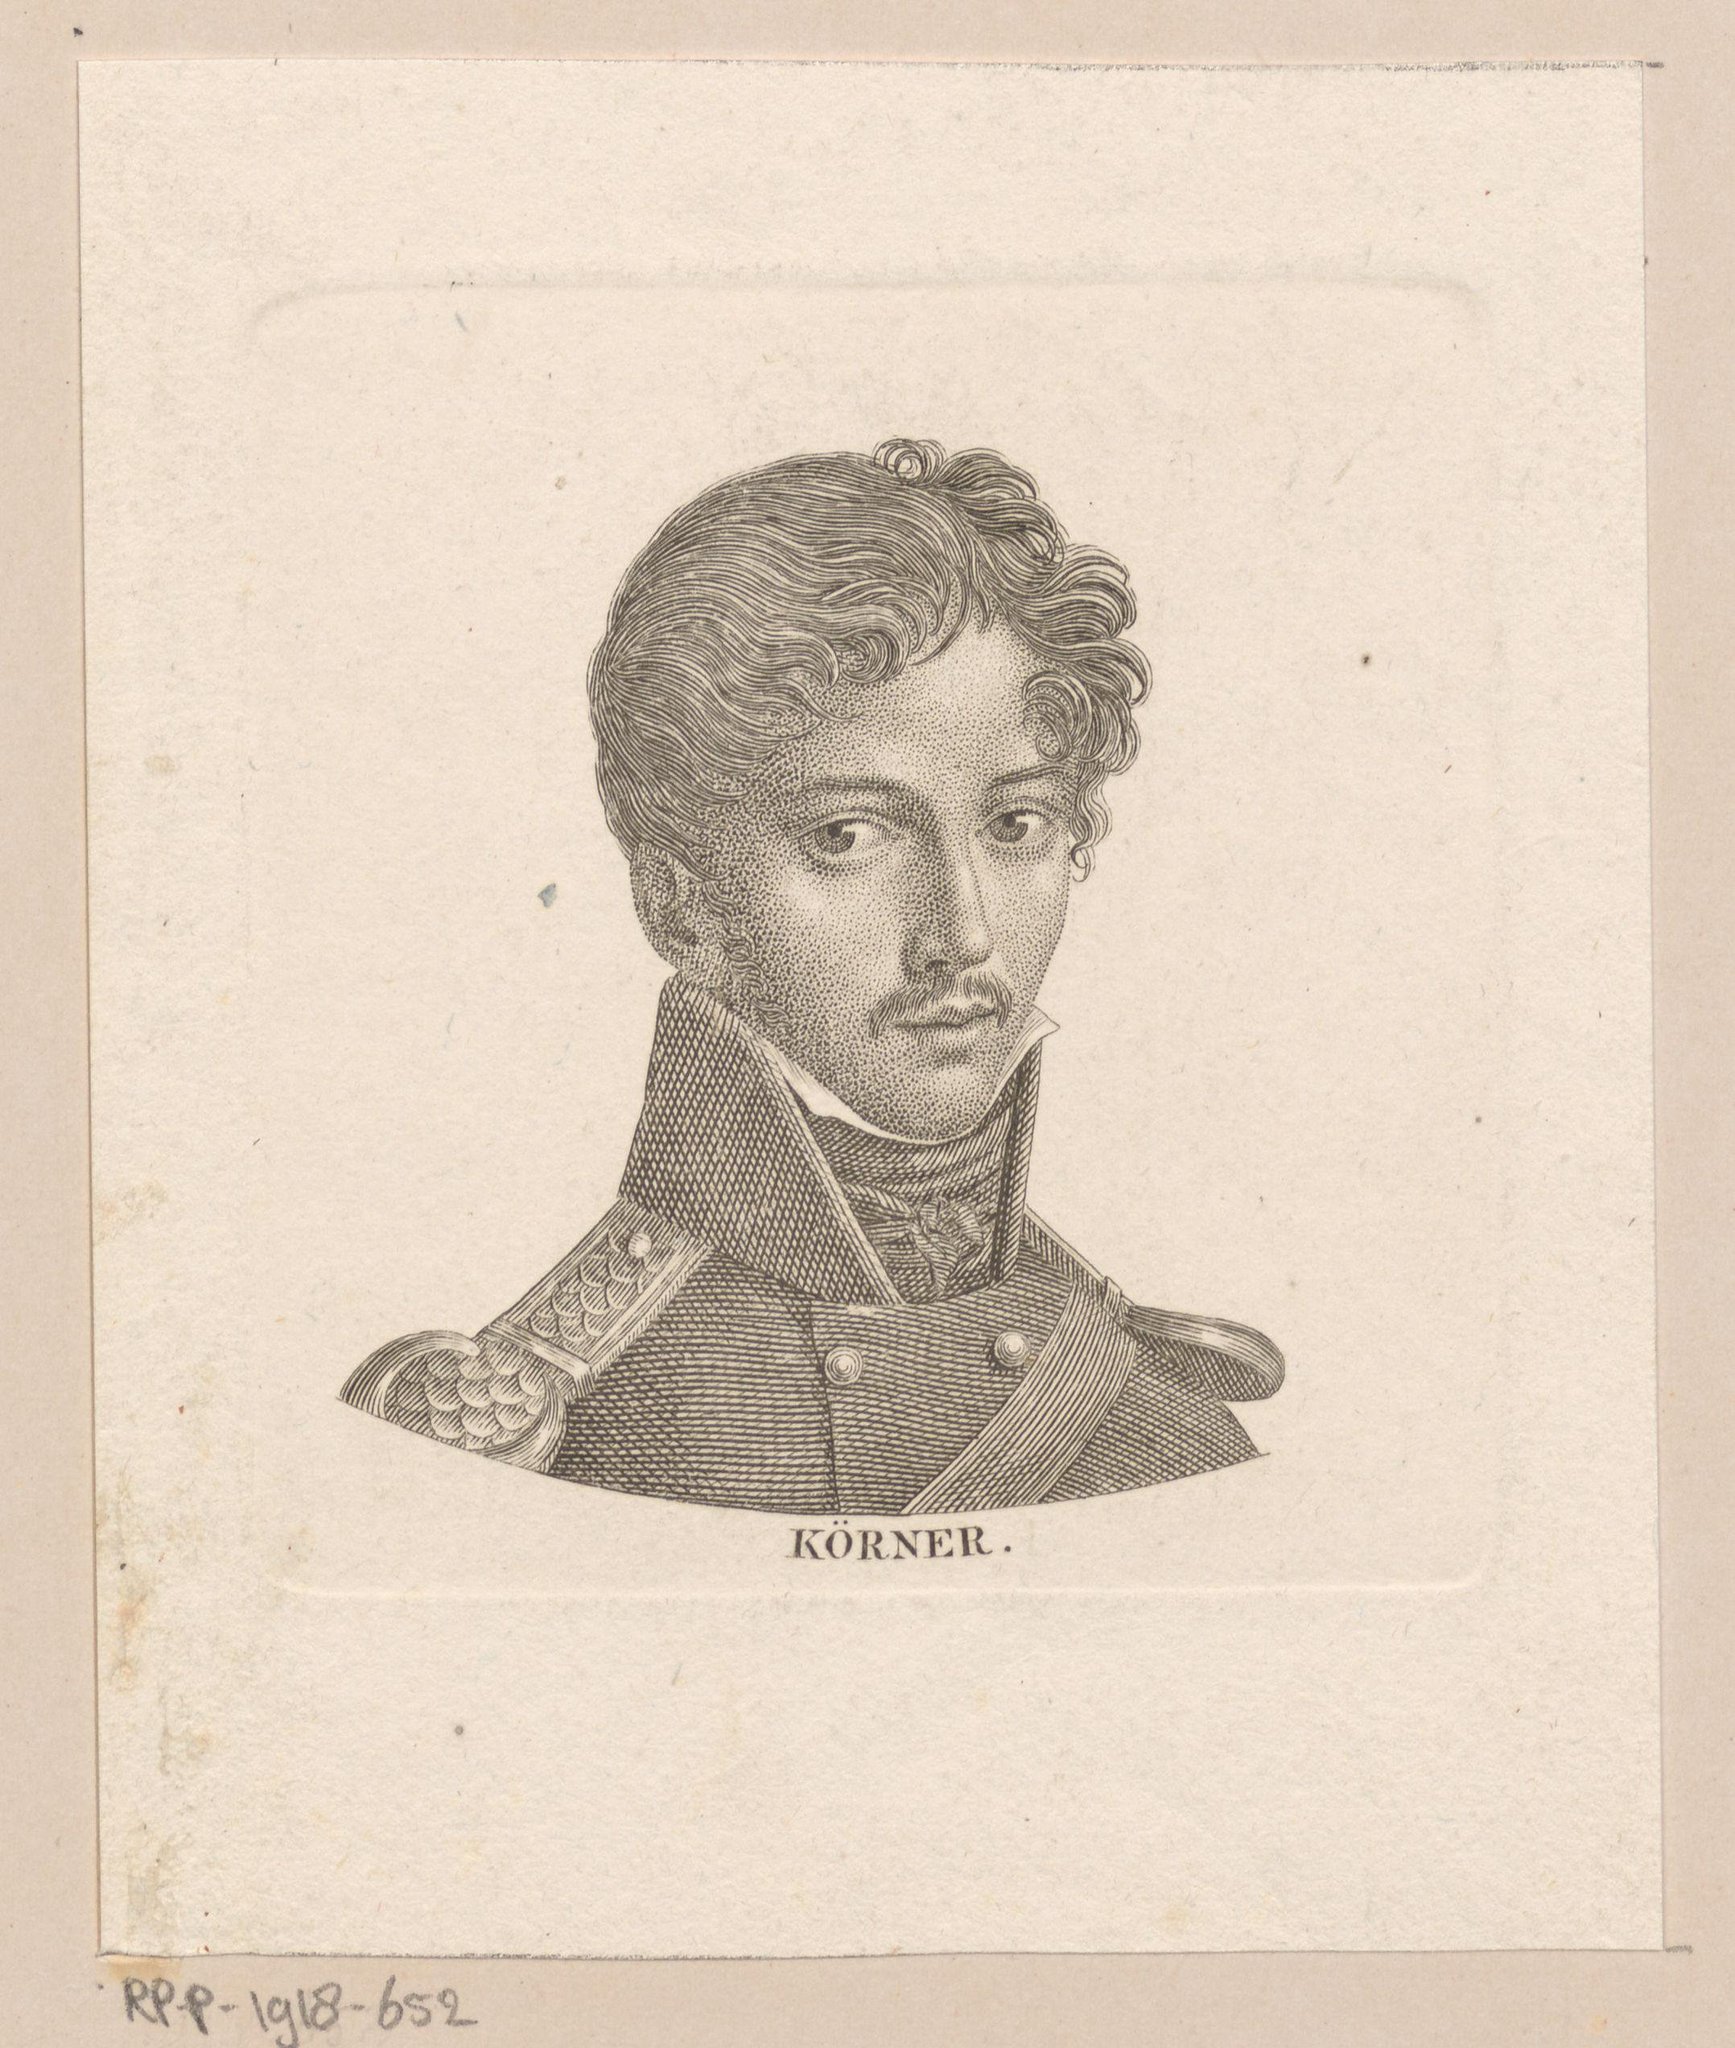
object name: print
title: Portret van Theodor Körner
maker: ernst ludwig riepenhausen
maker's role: print maker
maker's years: 1765-1840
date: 1801-1840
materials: paper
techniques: engraving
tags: historical persons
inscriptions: collector's mark: Lugt 2233